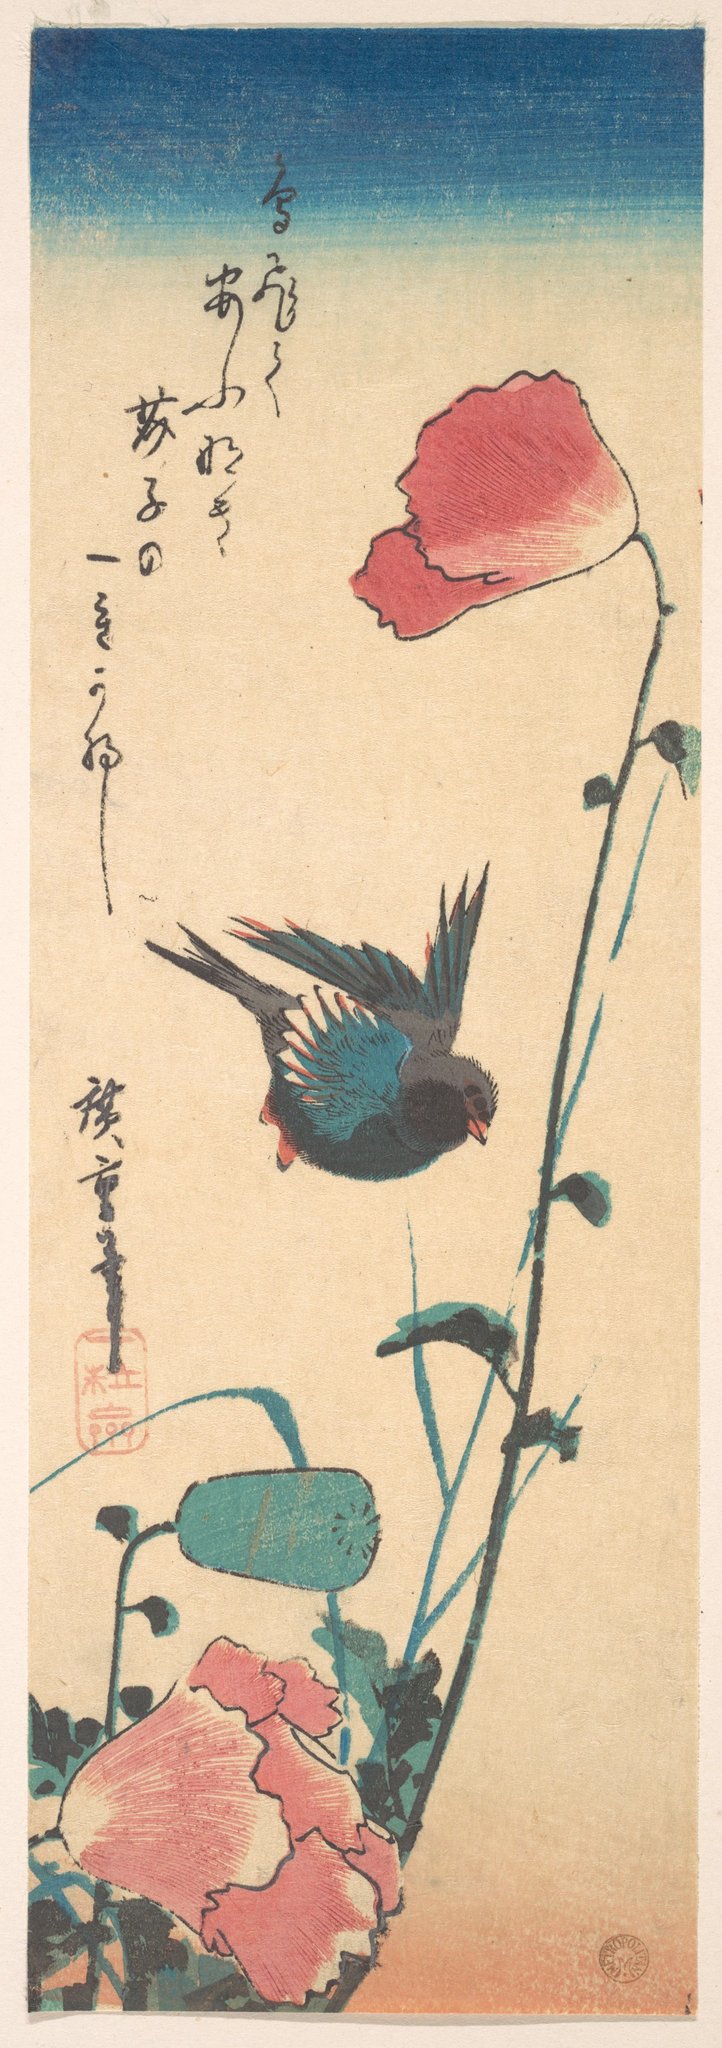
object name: print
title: Poppy and Sparrow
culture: japanese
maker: utagawa hiroshige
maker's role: artist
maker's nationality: japanese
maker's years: 1797-1858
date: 1833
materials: ink, paper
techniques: woodblock print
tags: birds,poppies